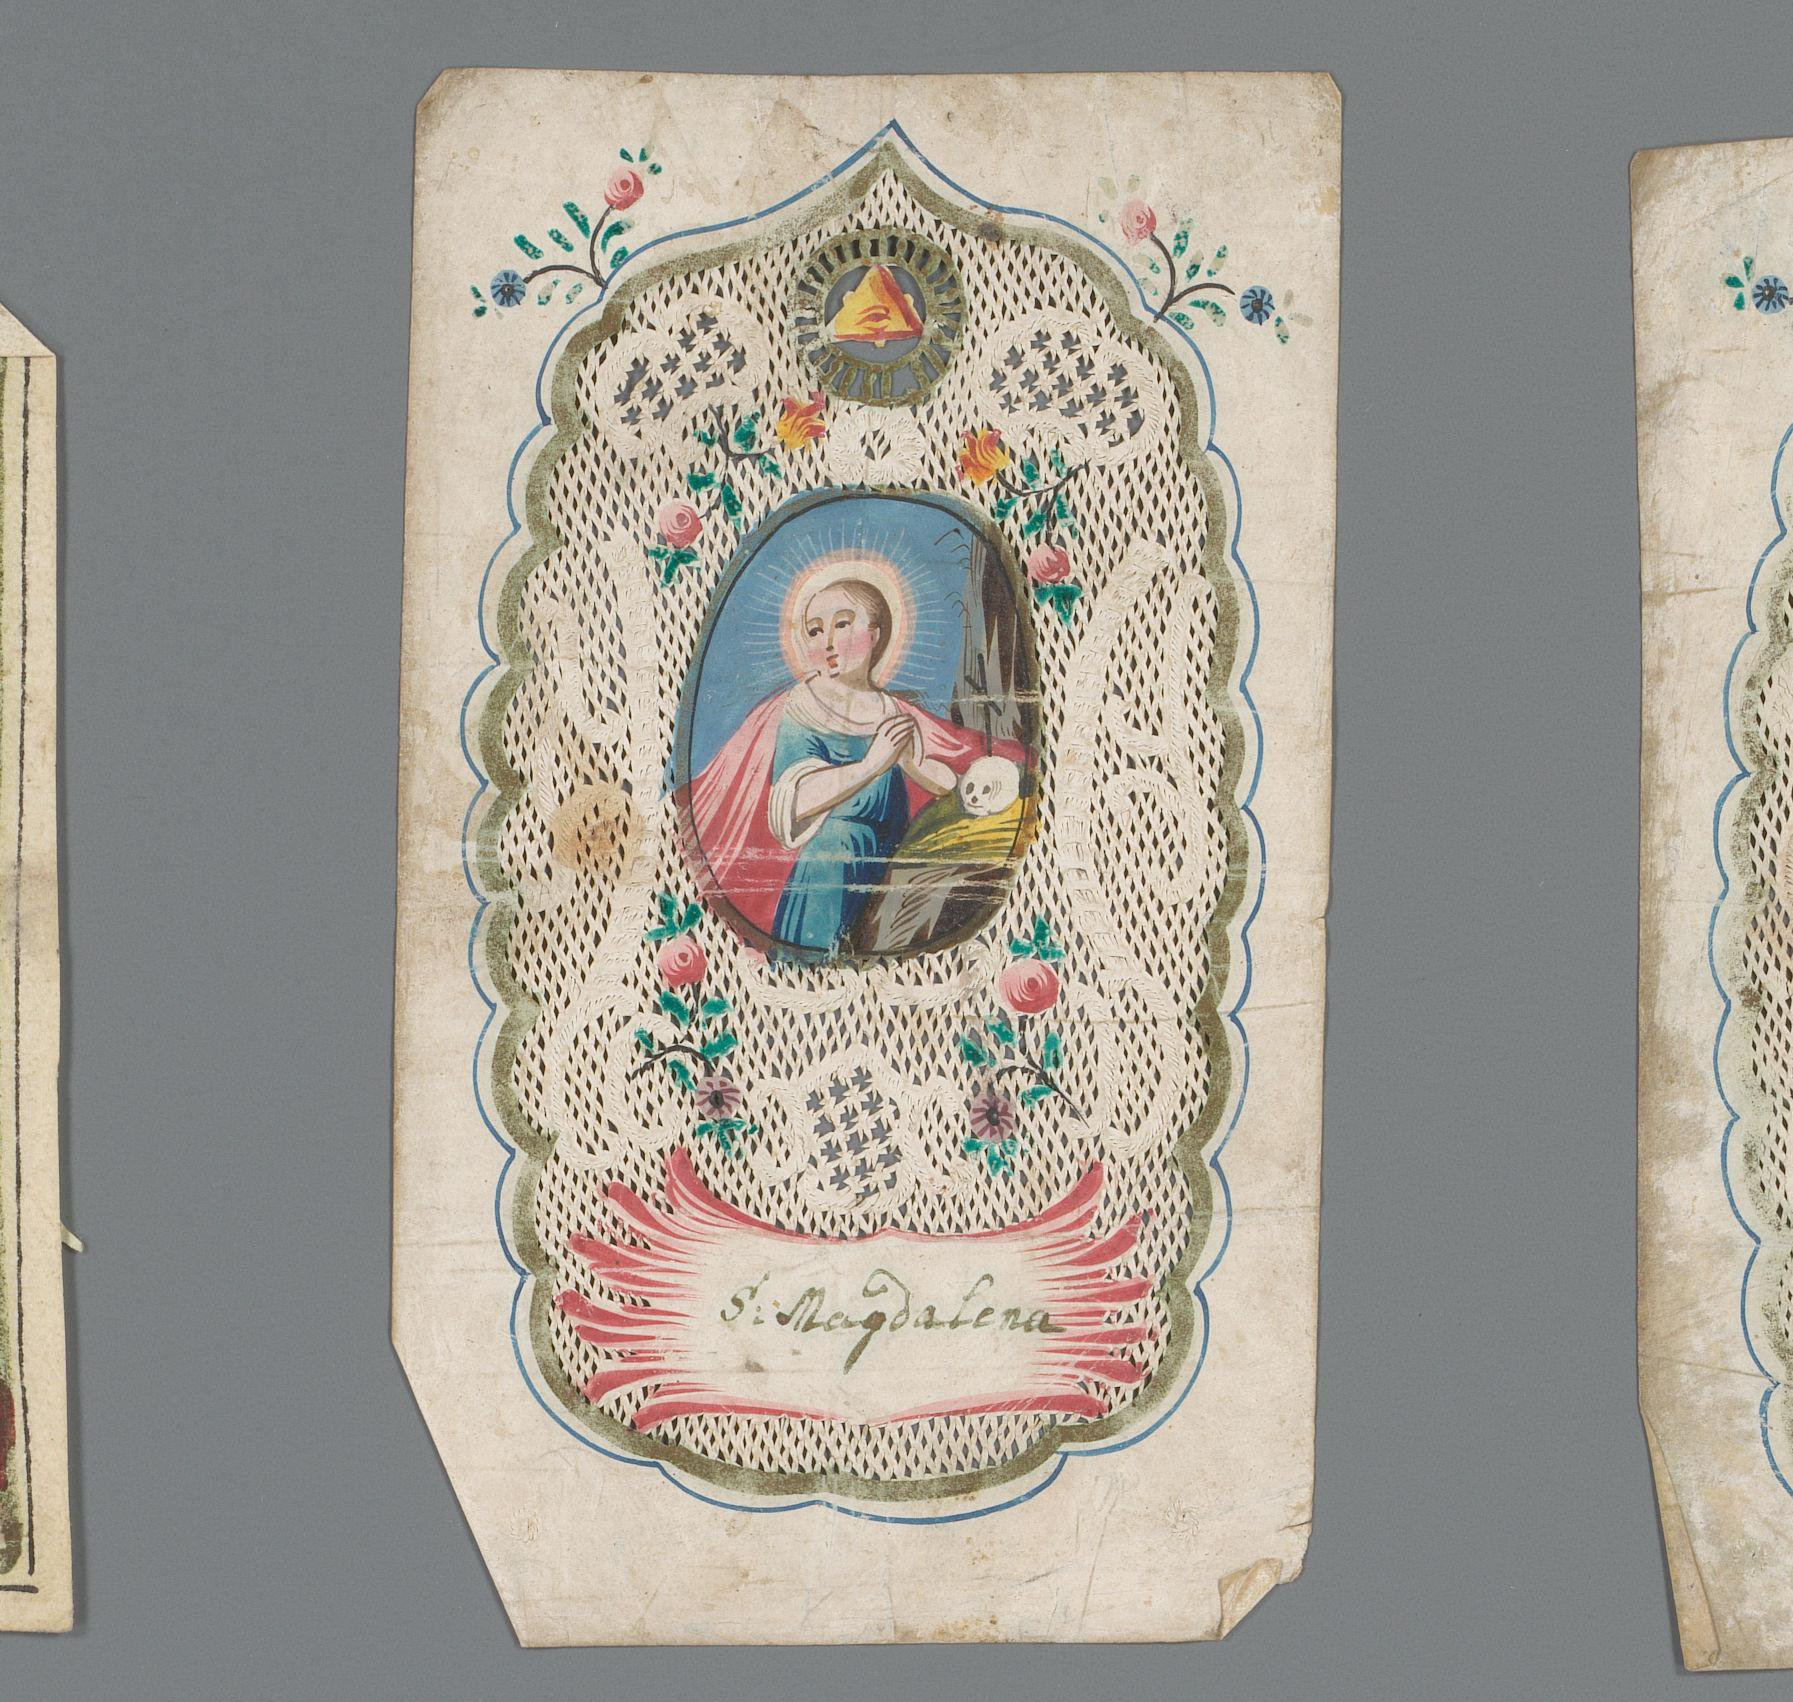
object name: cut paper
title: S. Magdalena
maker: Anonymous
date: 1750-1784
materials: paper, watercolor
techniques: cutting, drawing, snipping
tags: the penitent harlot mary magdalene; possible attributes: book (or scroll), crown, crown of thorns, crucifix, jar of ointment, mirror, musical instrument, palm-branch, rosary, scourge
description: De boetvaardige heilige Maria Magdalena in gebed naast een schedel in een uitgesneden decoratieve omlijsting met bloemen en krullen. Beneden een cartouche met de naam van de heilige.